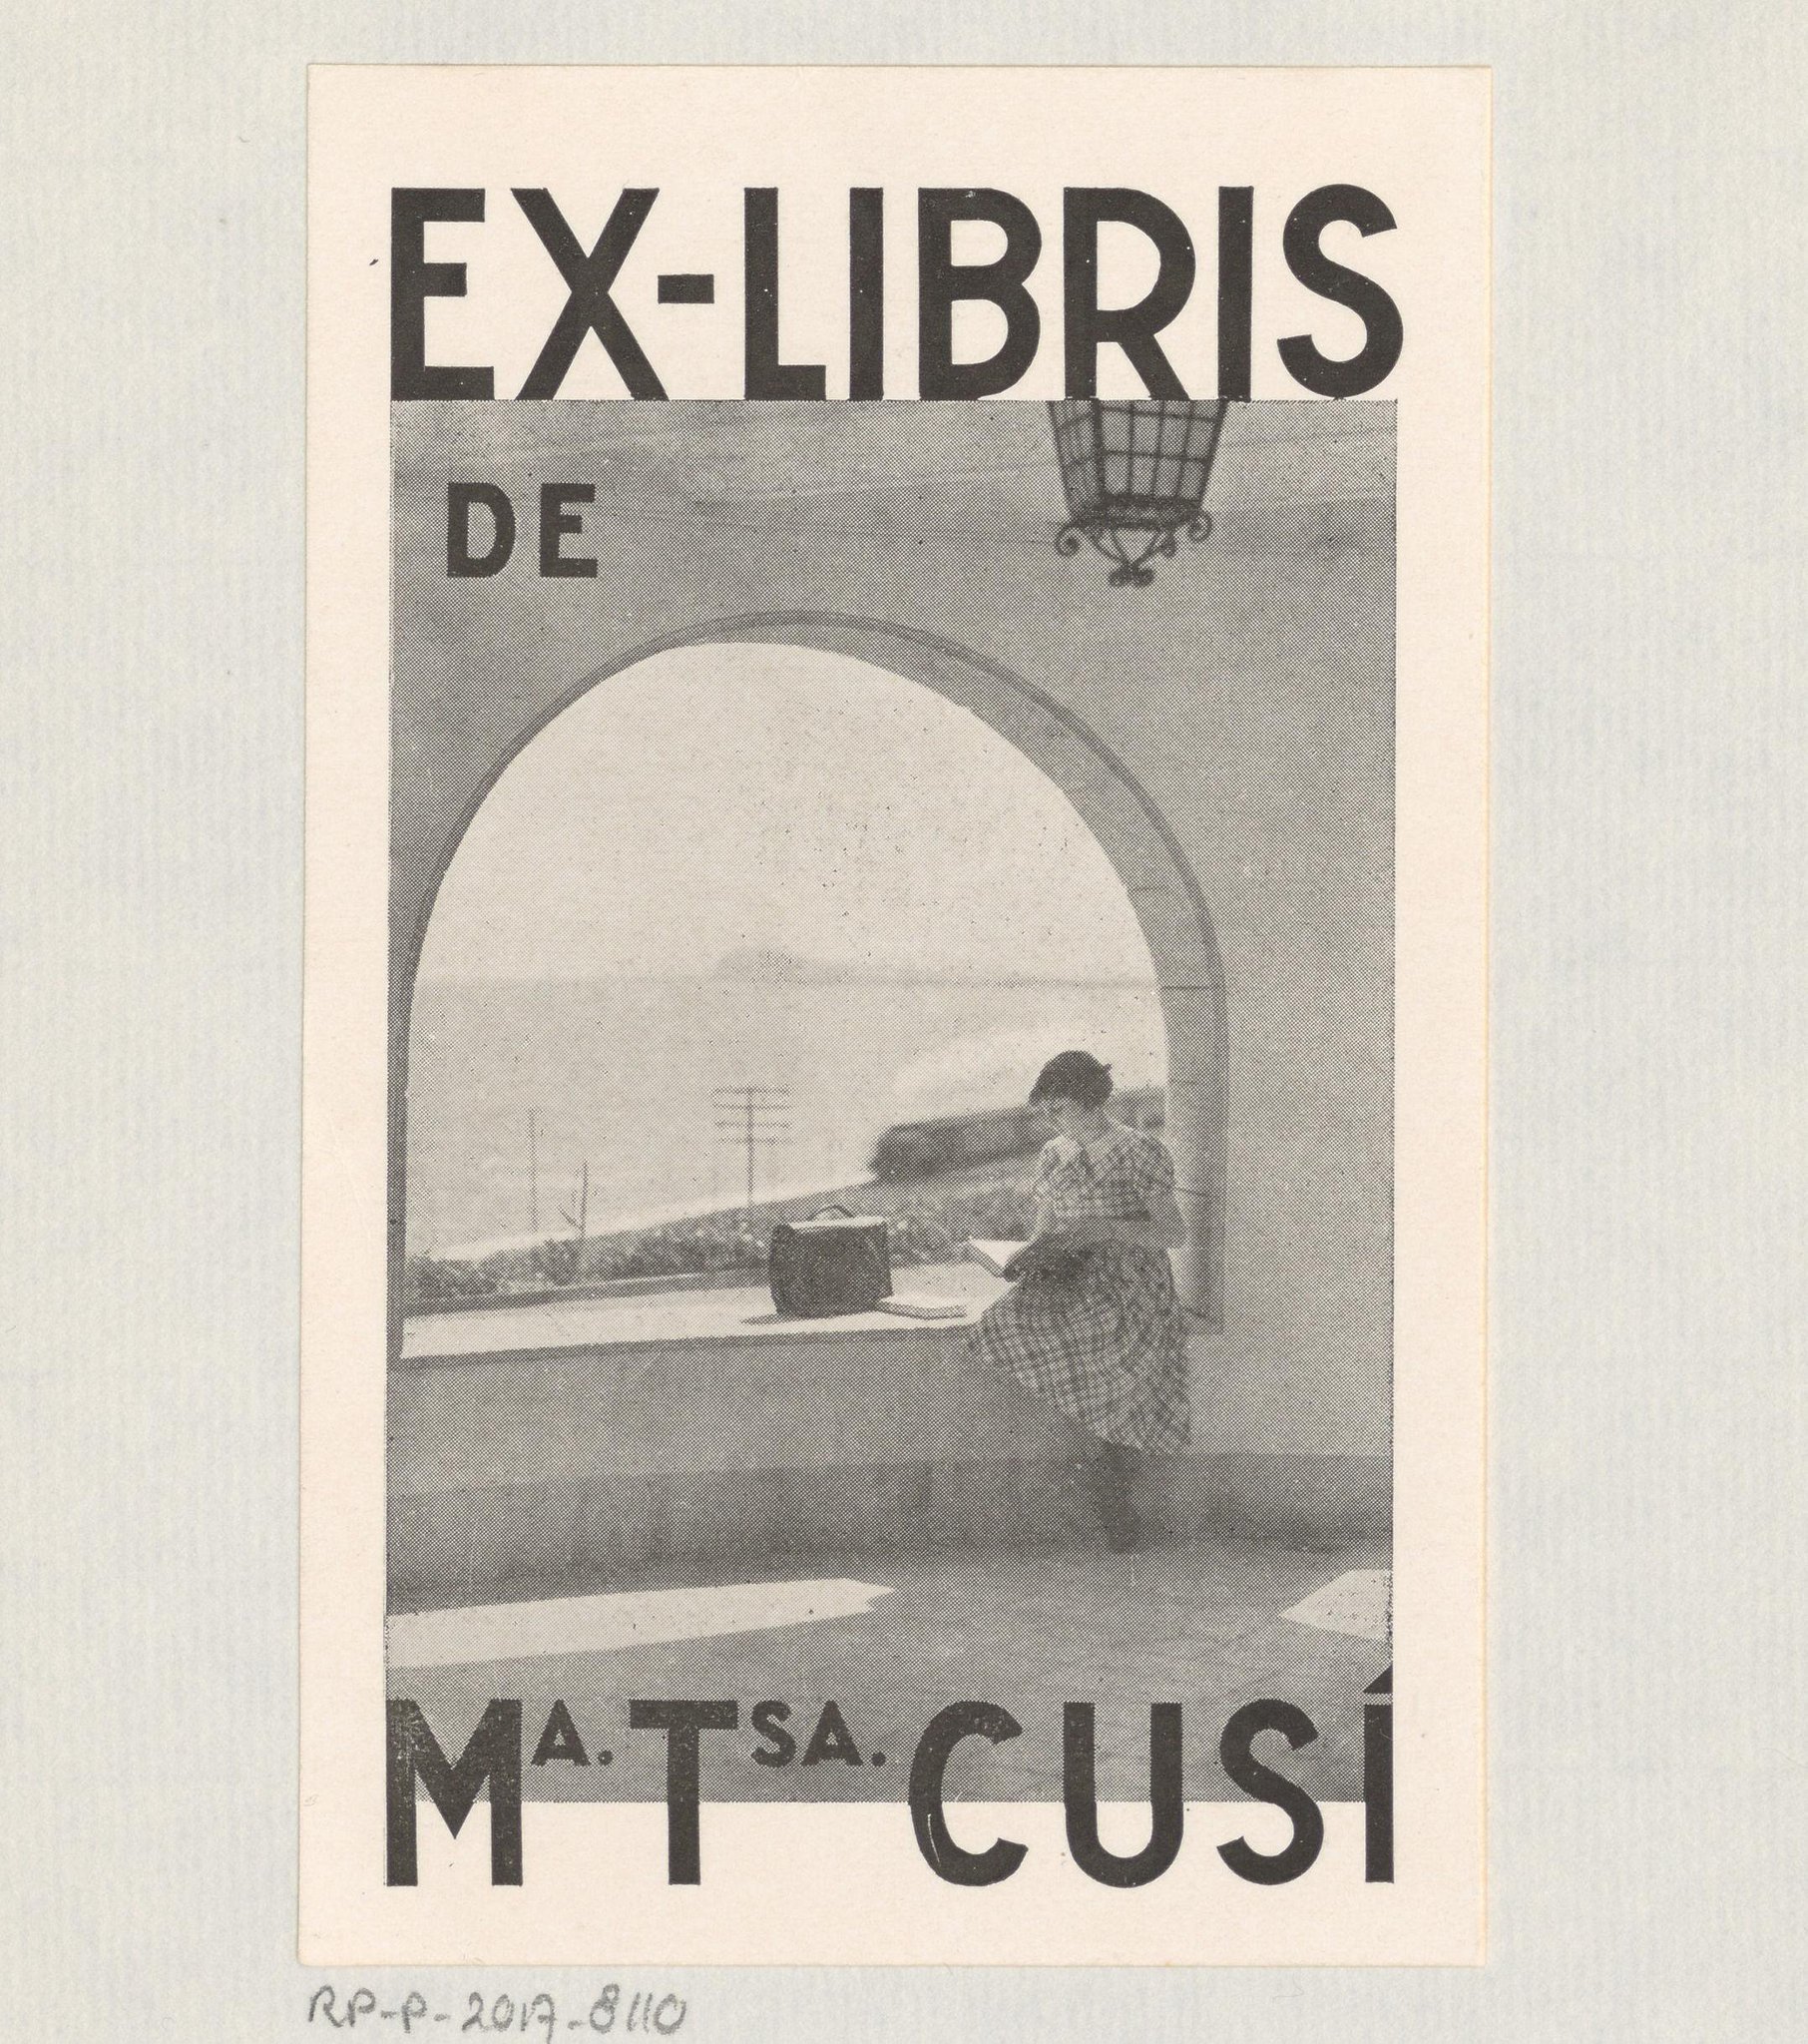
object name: photomechanical print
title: Ex-libris de Ma.Tsa. Cusí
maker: Anonymous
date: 1937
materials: paper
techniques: autotype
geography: spain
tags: reading, sitting figure - aa - female human figure, arch, archivolt ~ architecture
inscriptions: inscription: ‘El ex-libris de Ma. Teresa Cusí representa (...) Masnou, 9 abril de 1937.’